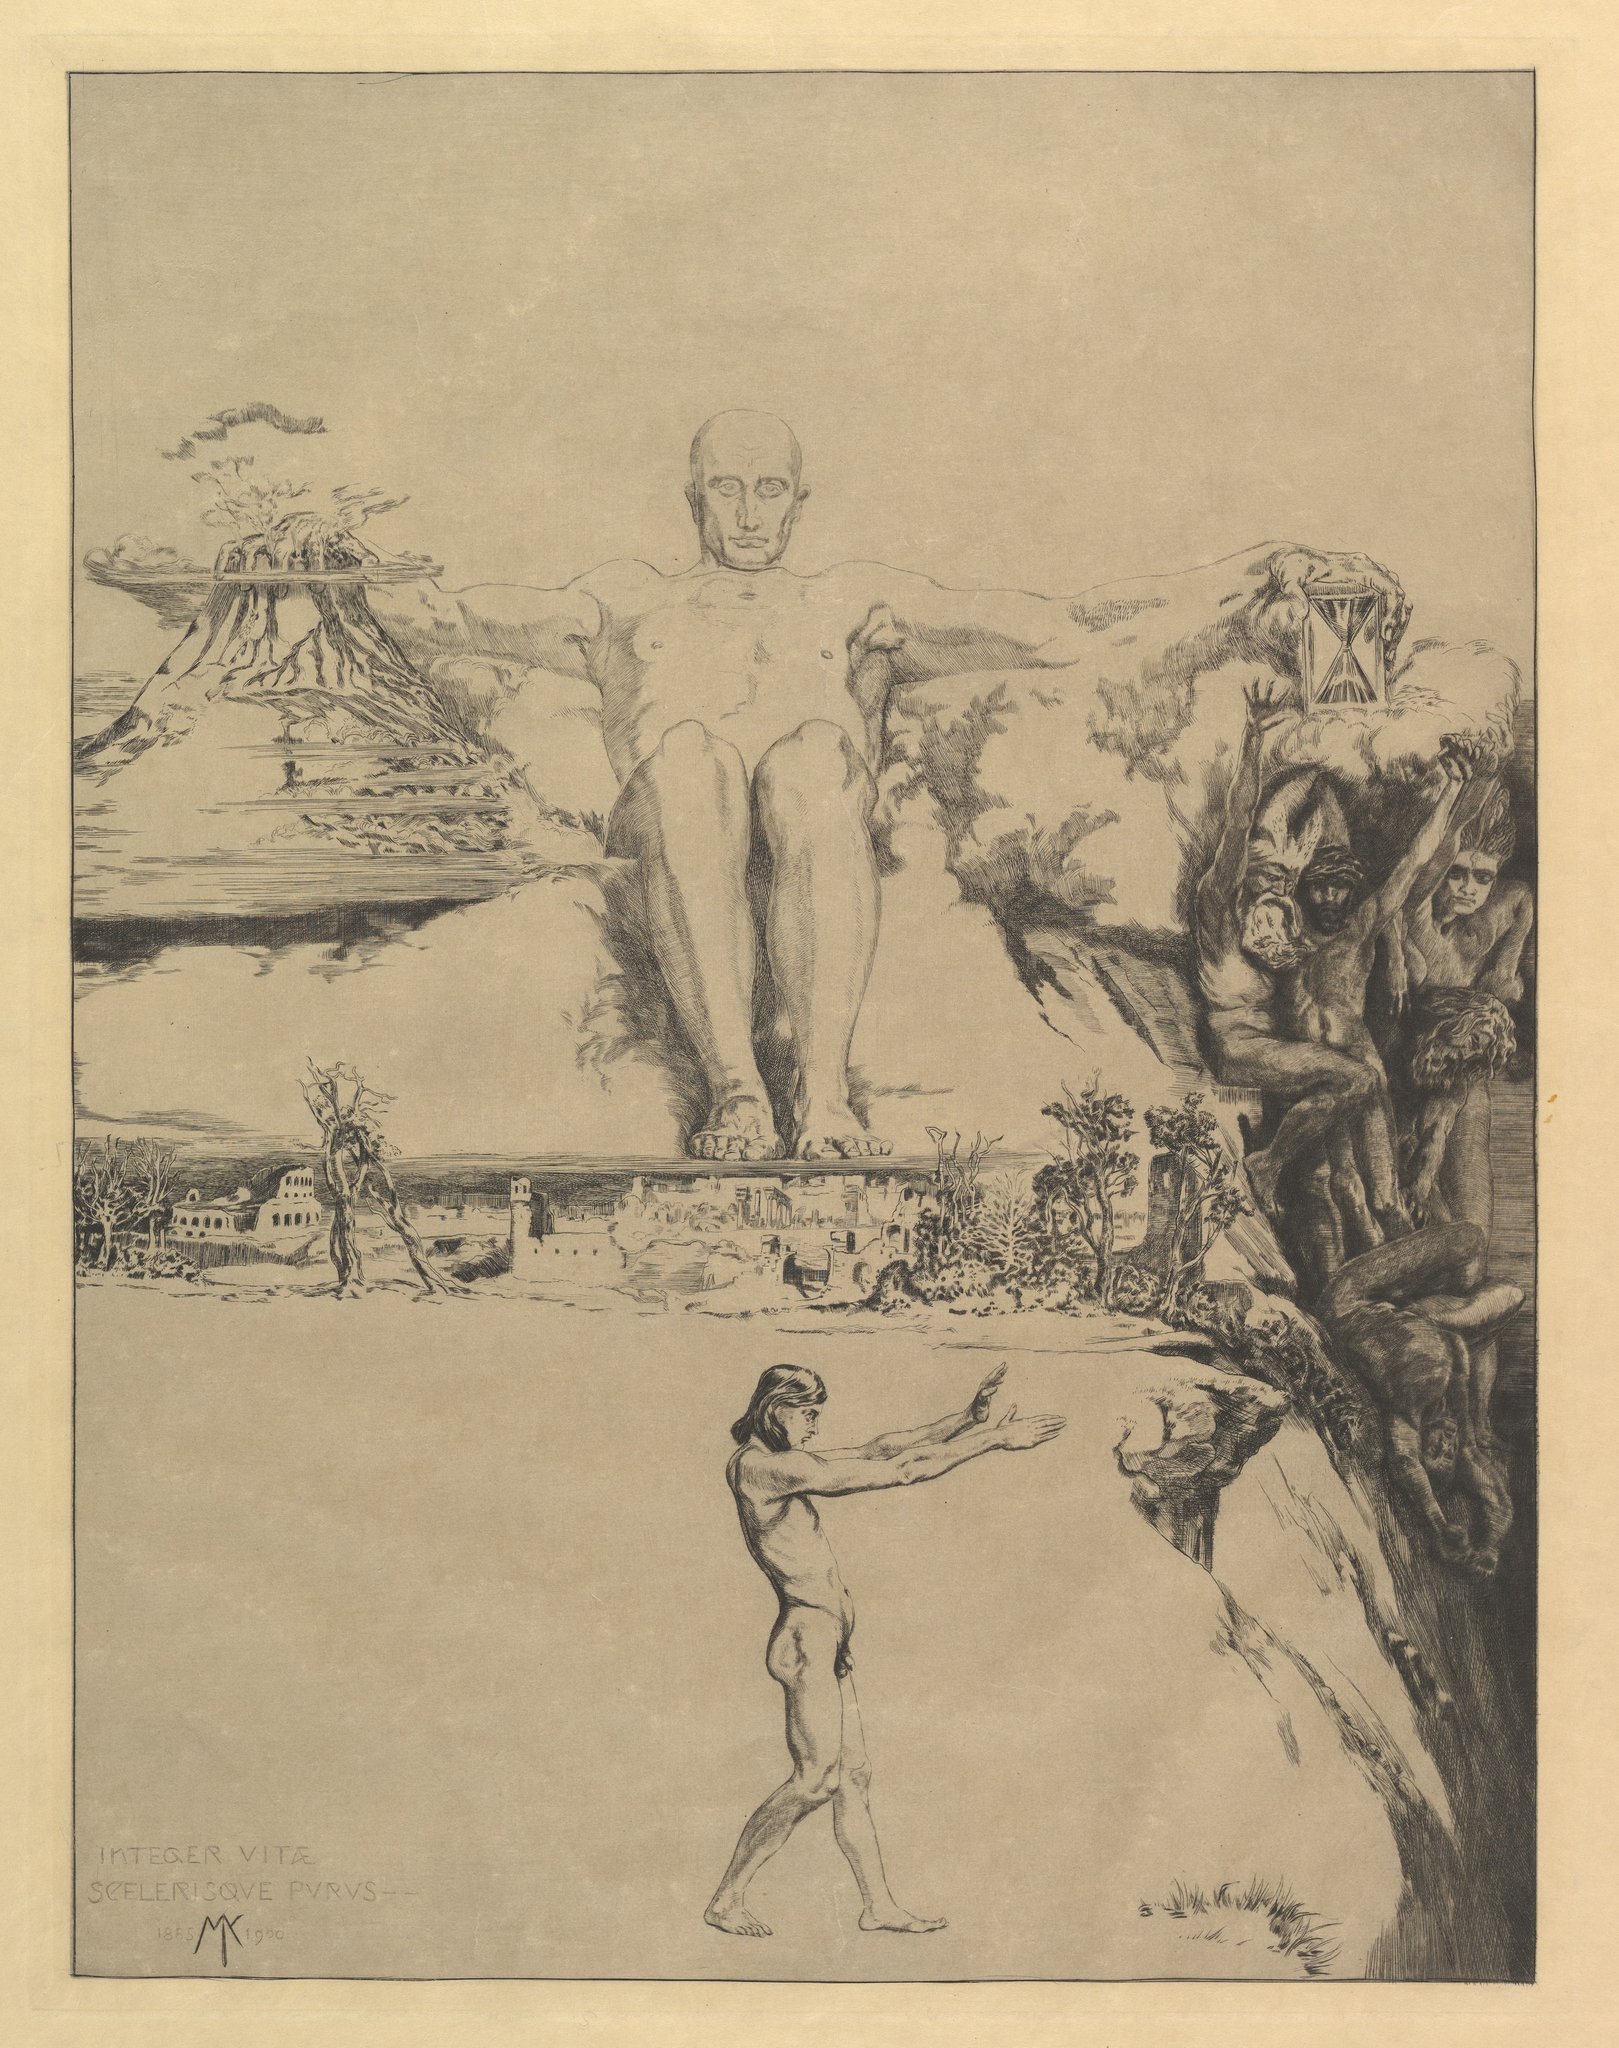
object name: print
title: "Integer Vitae...", from "Vom Tode Zweiter Teil"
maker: max klinger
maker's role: artist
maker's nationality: german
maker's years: 1857-1920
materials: copper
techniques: engraving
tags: male nudes,mountains